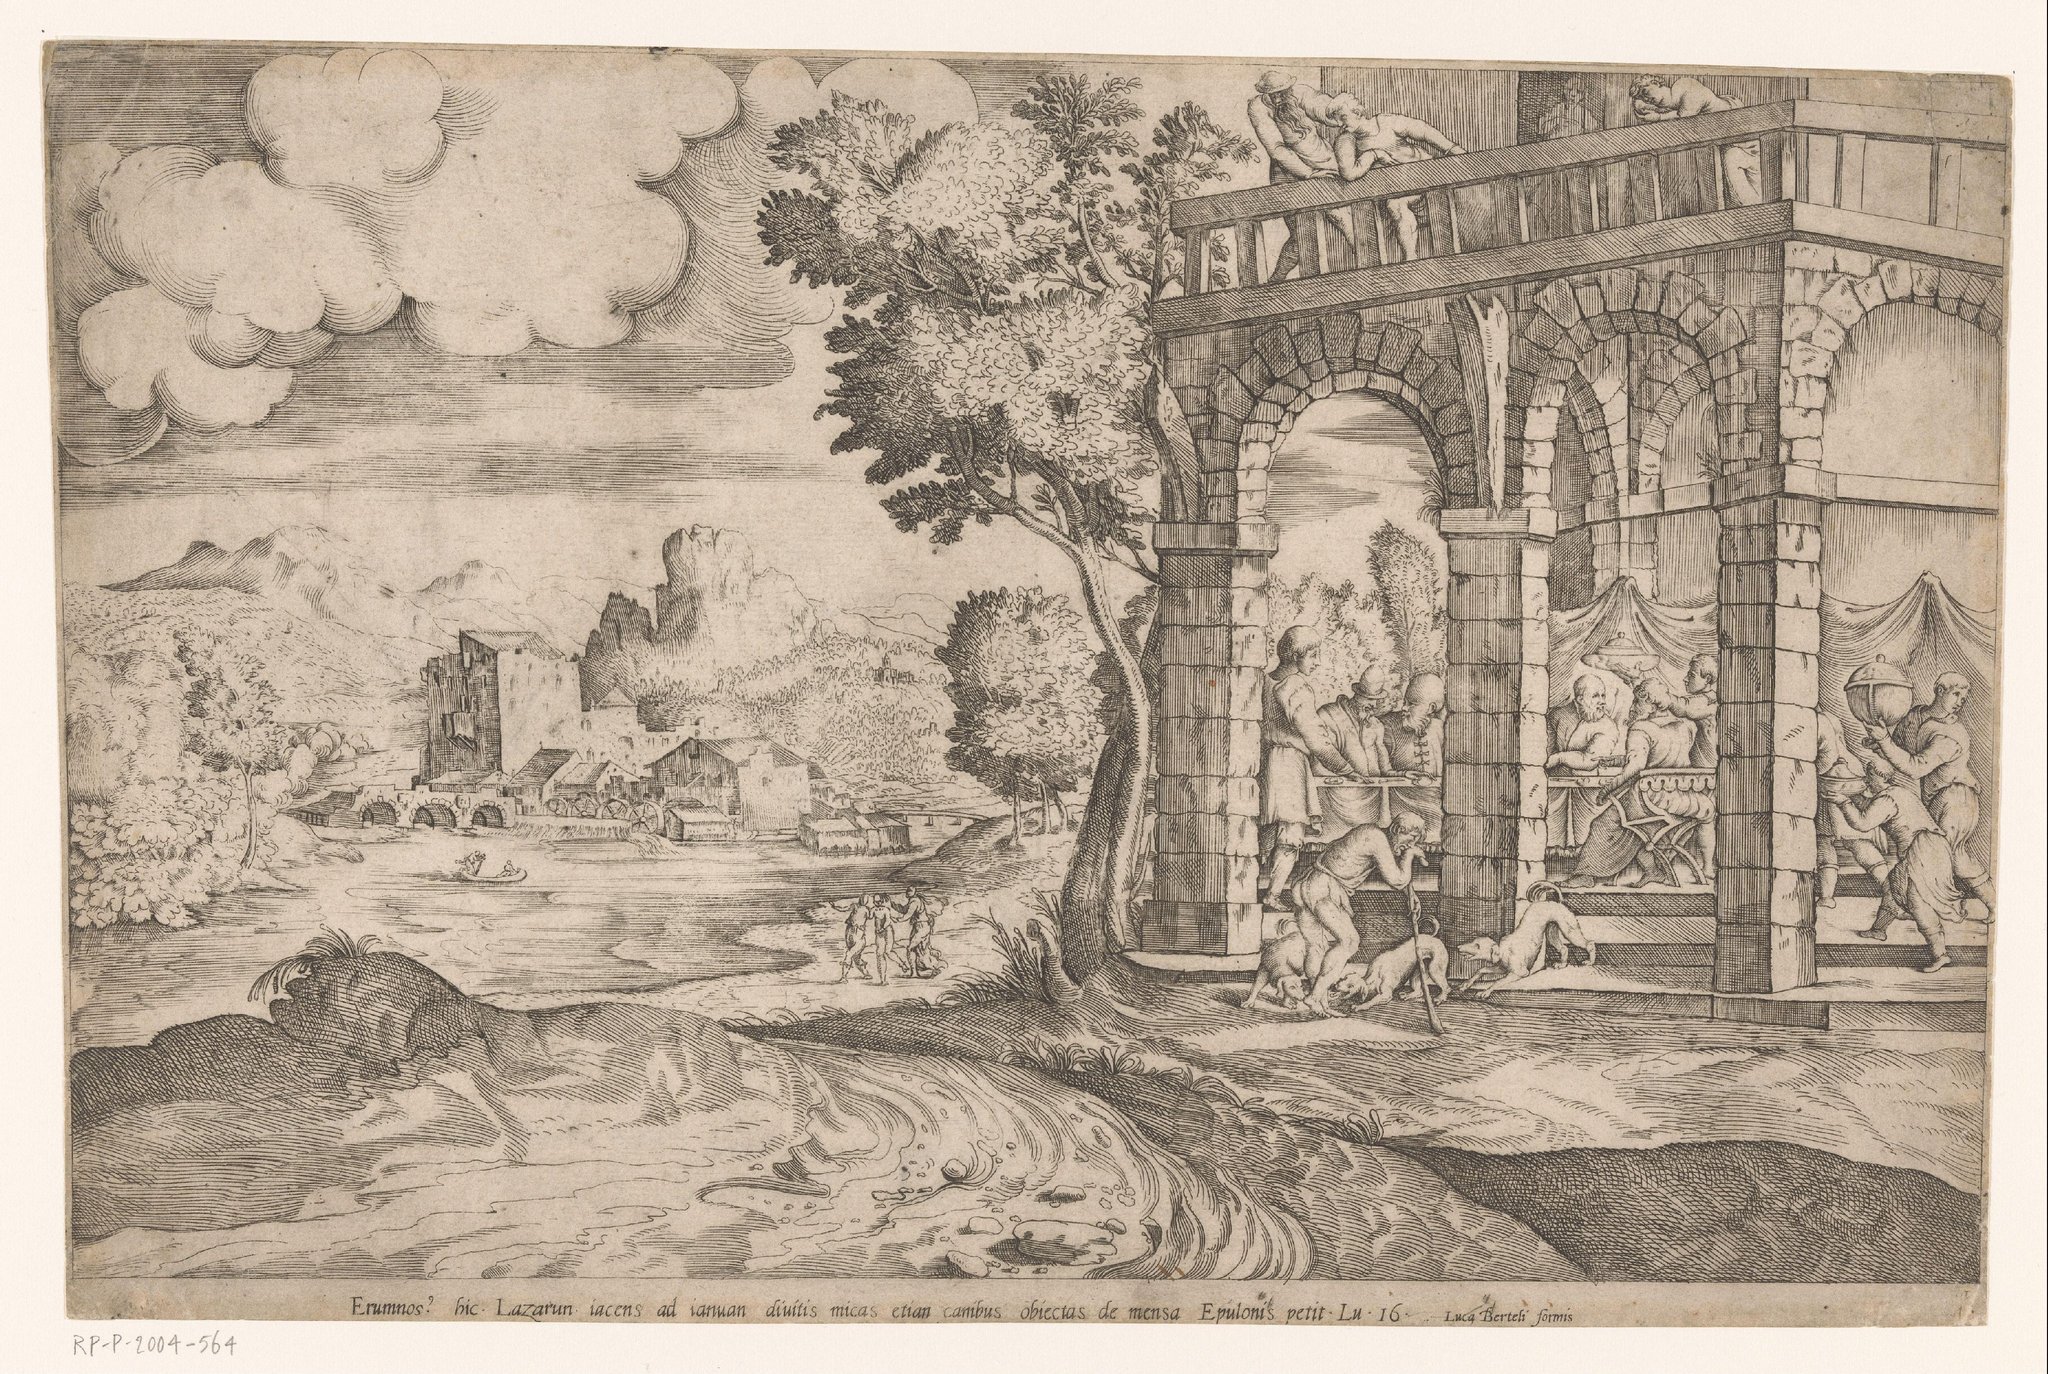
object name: print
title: Rijke man en de arme Lazarus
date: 1570-1660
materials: paper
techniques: engraving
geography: italy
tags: city-view, and landscape with man-made constructions, the rich man (dives) is feasting, while poor lazarus is starving at the gate (dogs licking lazarus' sores) (luke 16:19-31)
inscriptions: collector's mark: Lugt 2228, inscription: ‘antonio travi de sestri’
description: Rechts op een overdekt terras zit de rijke man met een gezelschap aan een tafel. Buiten aan de rand van het terras de arme Lazarus, wiens wonden worden gelikt door honden. Links op de achtergrond een rivierlandschap. Een regel Latijnse tekst in ondermarge.